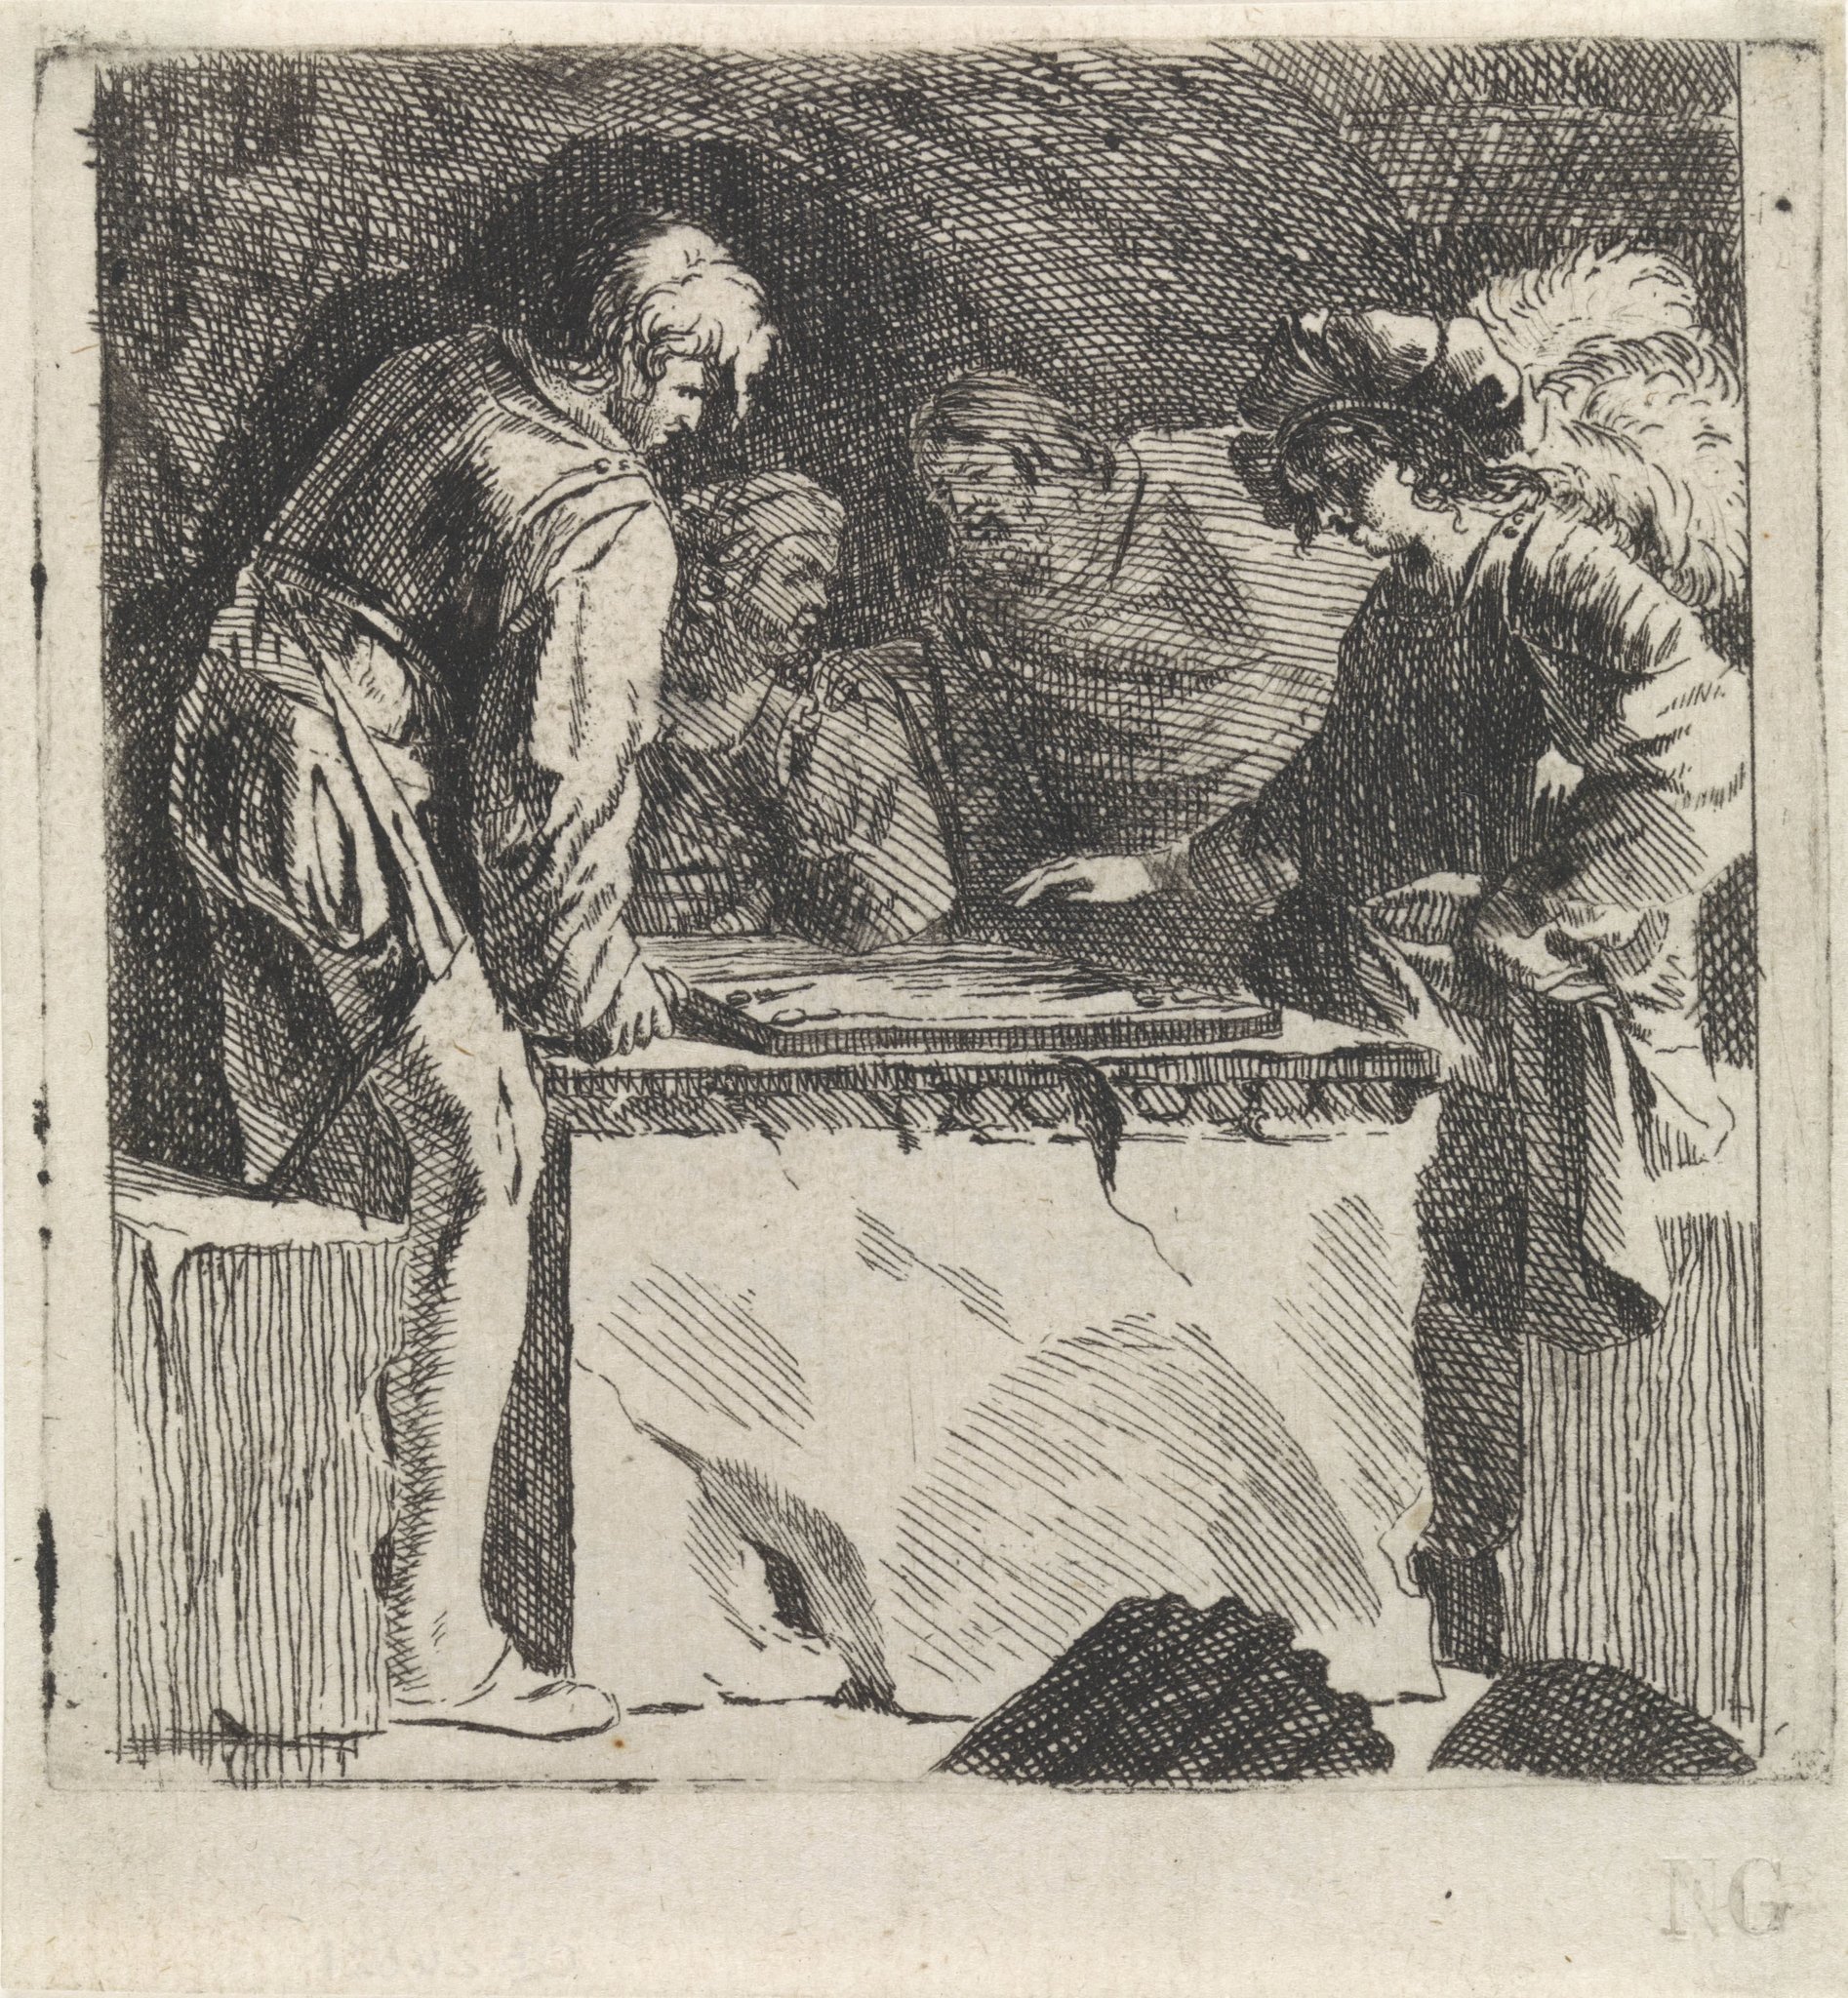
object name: print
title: Triktrakspelers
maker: p. zaal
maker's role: print maker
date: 1600-1699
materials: paper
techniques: etching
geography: netherlands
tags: backgammon, tric-trac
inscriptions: collector's mark: Lugt 2228, inscription: ‘Als P. Zaal geteekend op het exempl. bij den heer Weber. Deze aanteekening is van den heer Vis Blokhuyzen. v.d.K.’, collector's mark: Lugt 1967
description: Vier mannen spelen triktrak. Rechts een man met een veer op zijn hoed.